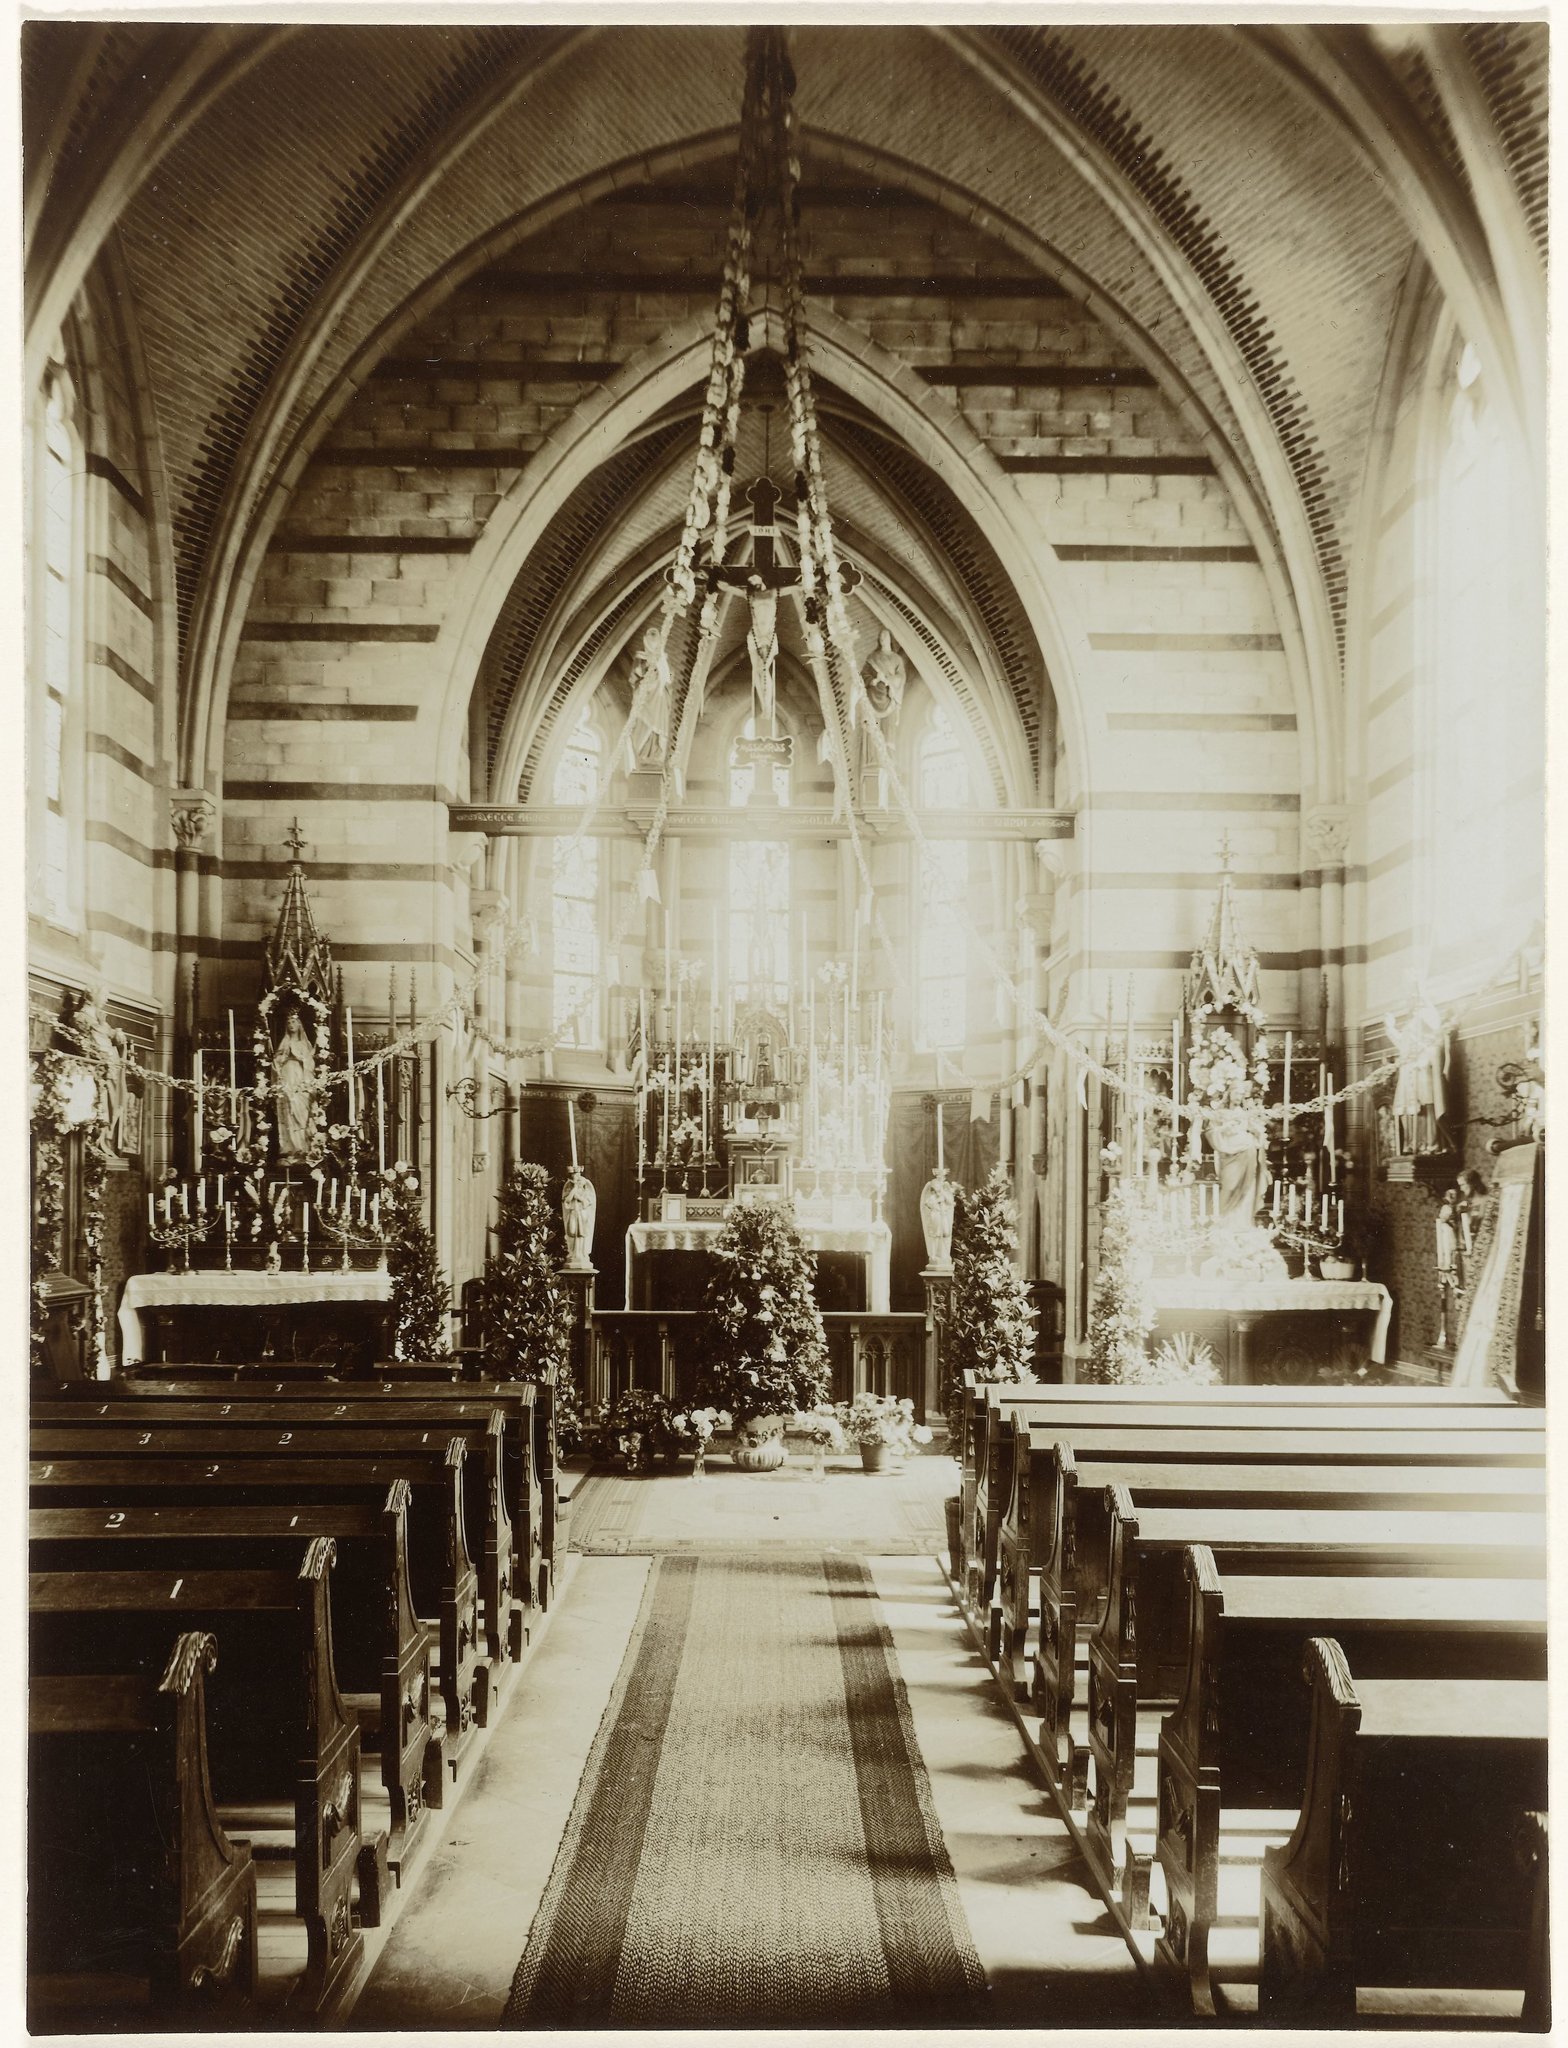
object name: photograph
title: Interieur van een katholieke kerk, zicht op het koor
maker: richard tepe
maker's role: fotograaf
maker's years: 1864-1952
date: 1900-1940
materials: photographic support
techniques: gelatin silver print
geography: netherlands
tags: interior of church